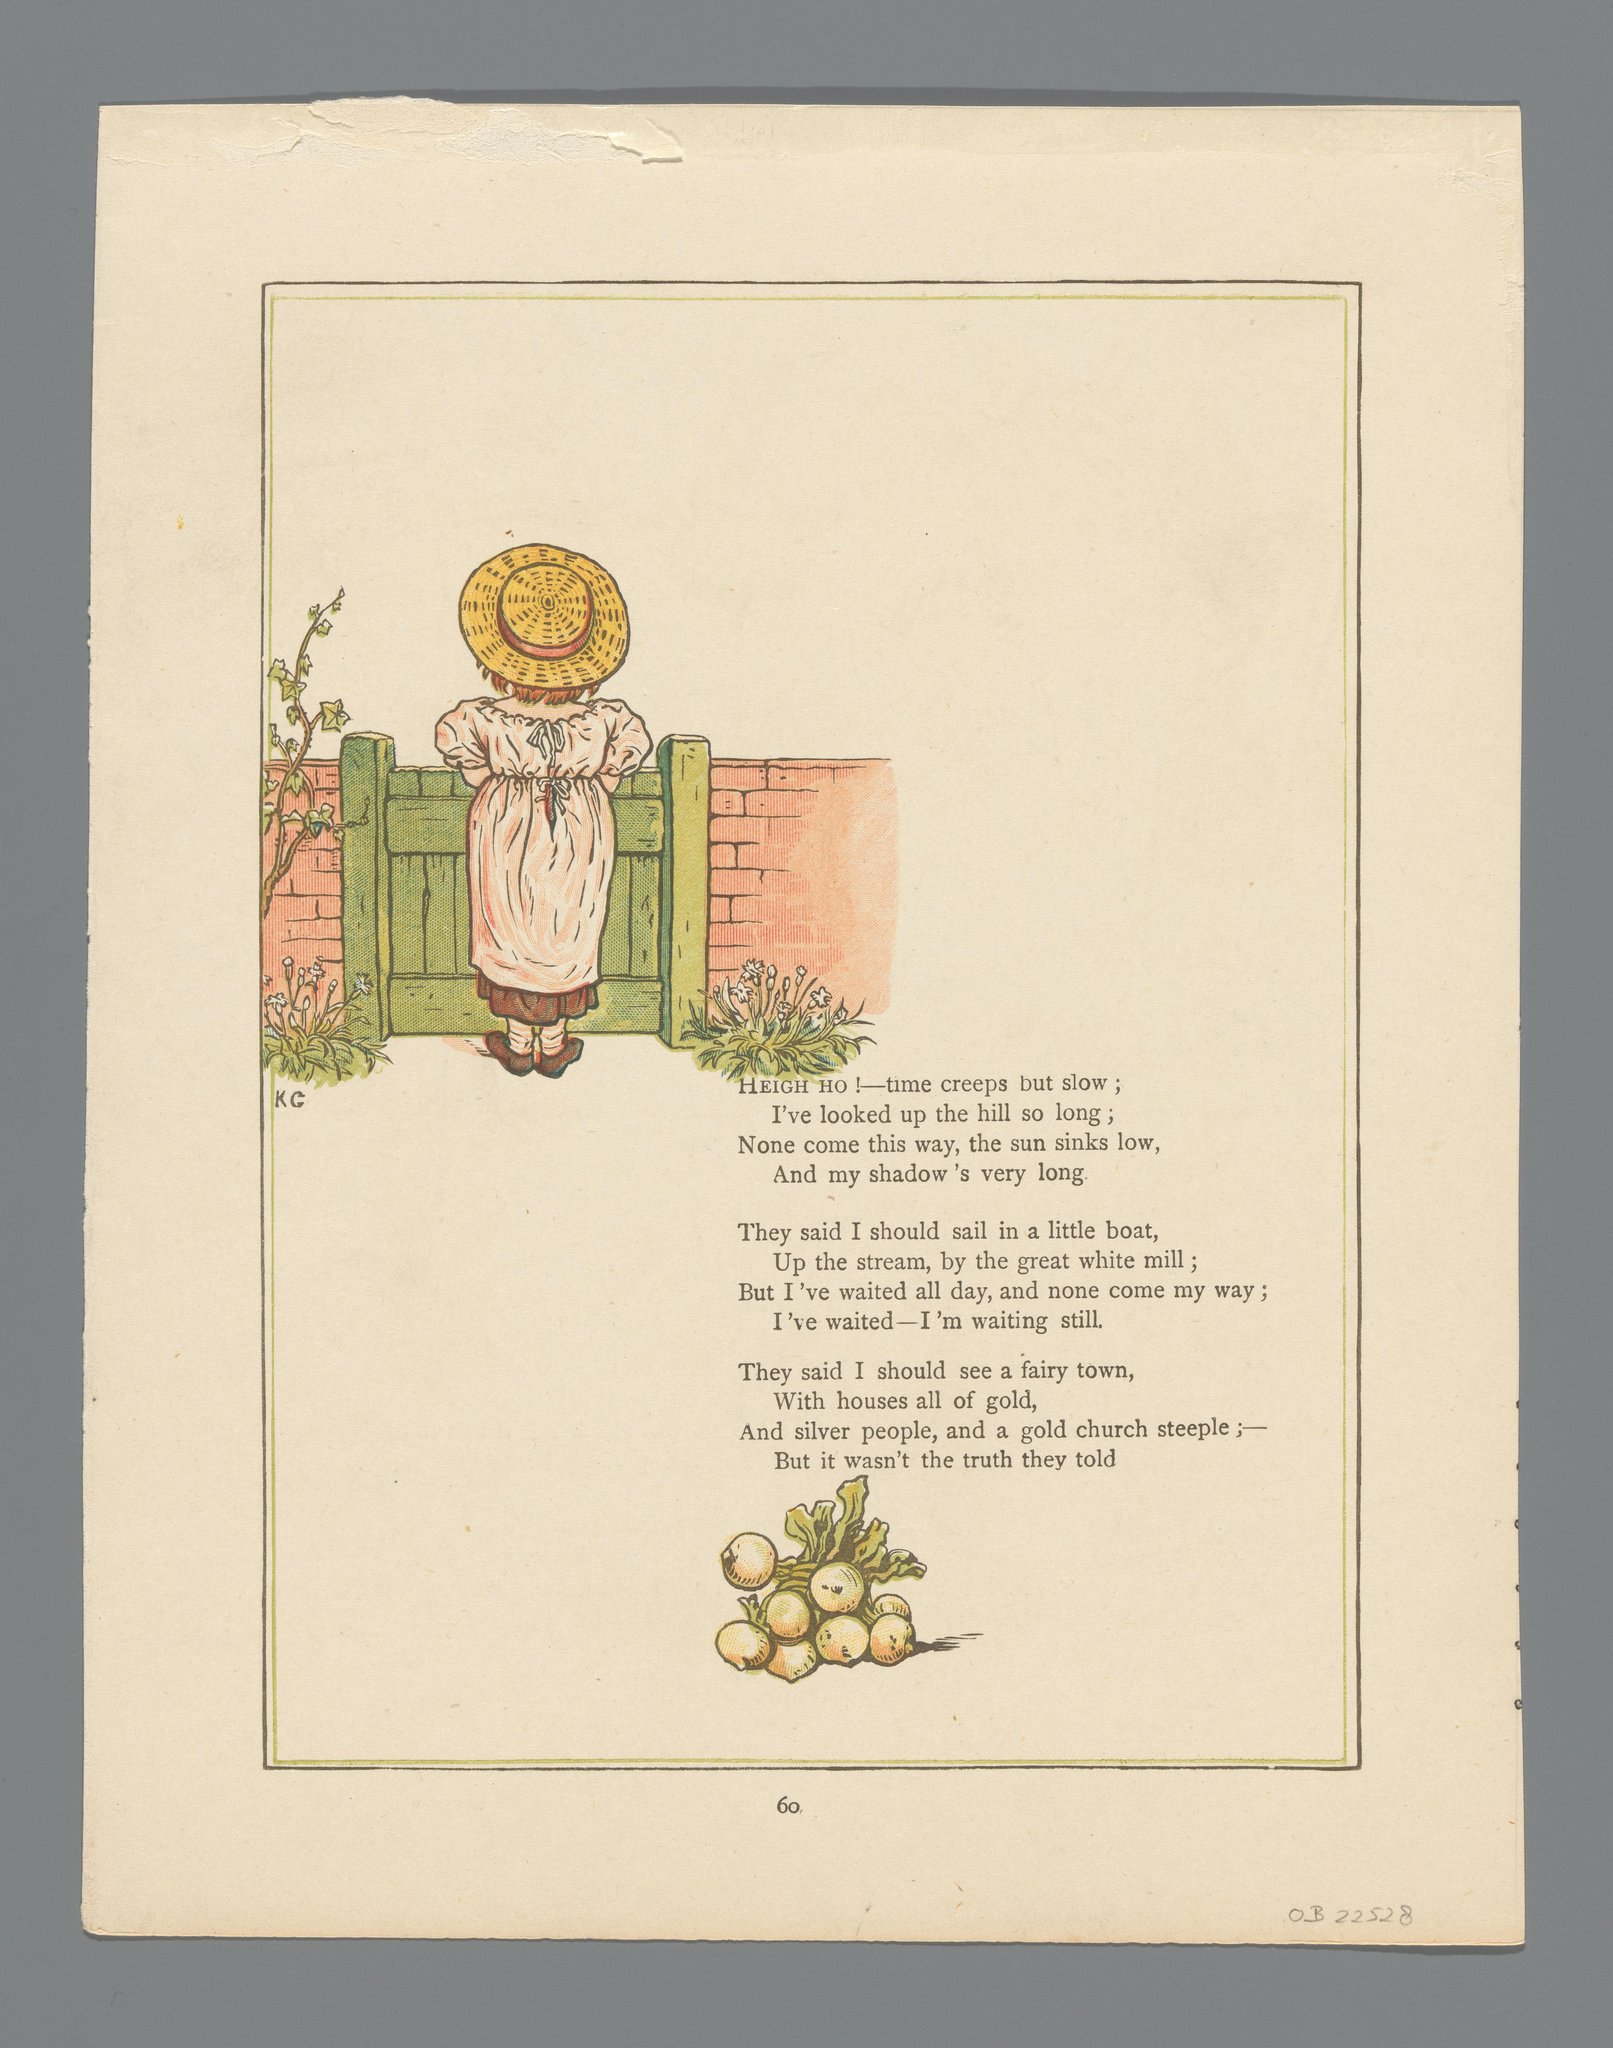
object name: book illustration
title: Meisje bij een poort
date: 1878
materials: paper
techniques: wood engraving, letterpress printing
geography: london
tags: products of plants in general, girl (child between toddler and youth), gate, entrance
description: Prent uit: Greenaway, Kate. Under the window, pictures & rhymes for children. Londen: George Routledge & Sons, 1878, p. 60.